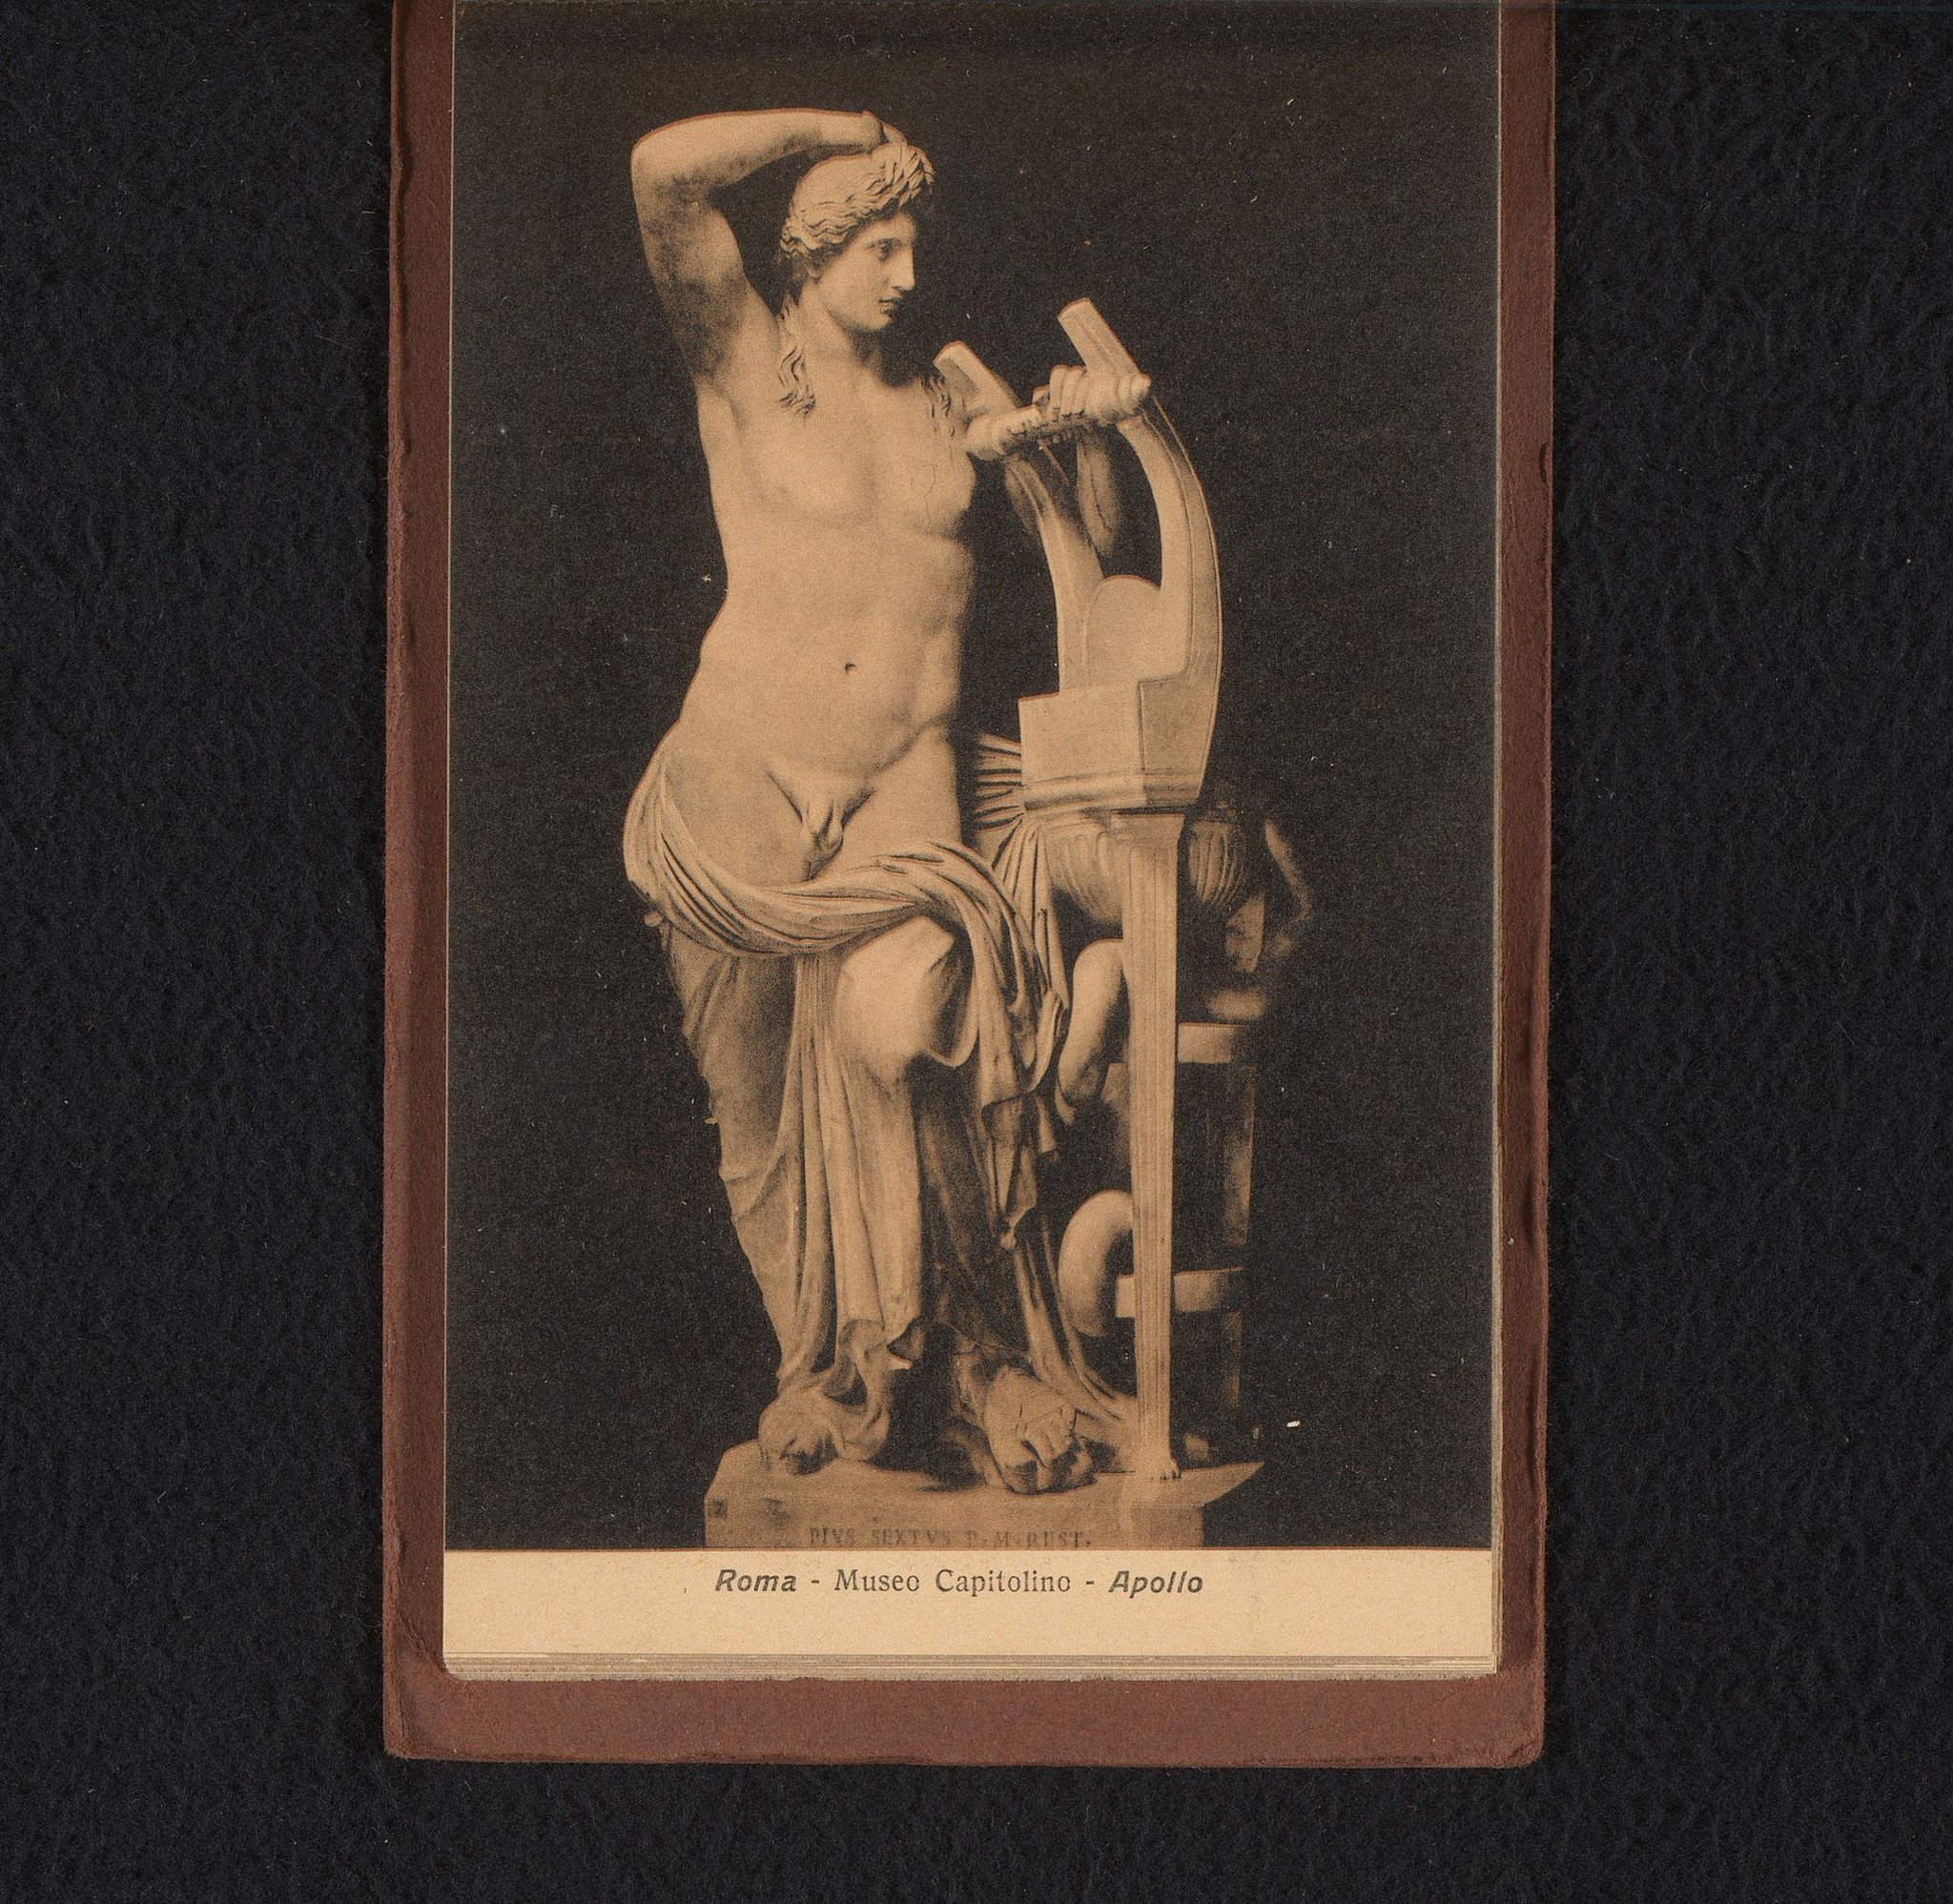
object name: photomechanical print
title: Roma - Museo Capitolino - Apollo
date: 1905-1930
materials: cardboard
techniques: photograph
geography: rome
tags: statues, paintings, etc. ~ objects of worship in roman religion, permanent exhibition, museum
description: Prentbriefkaart maakt deel uit van een album.